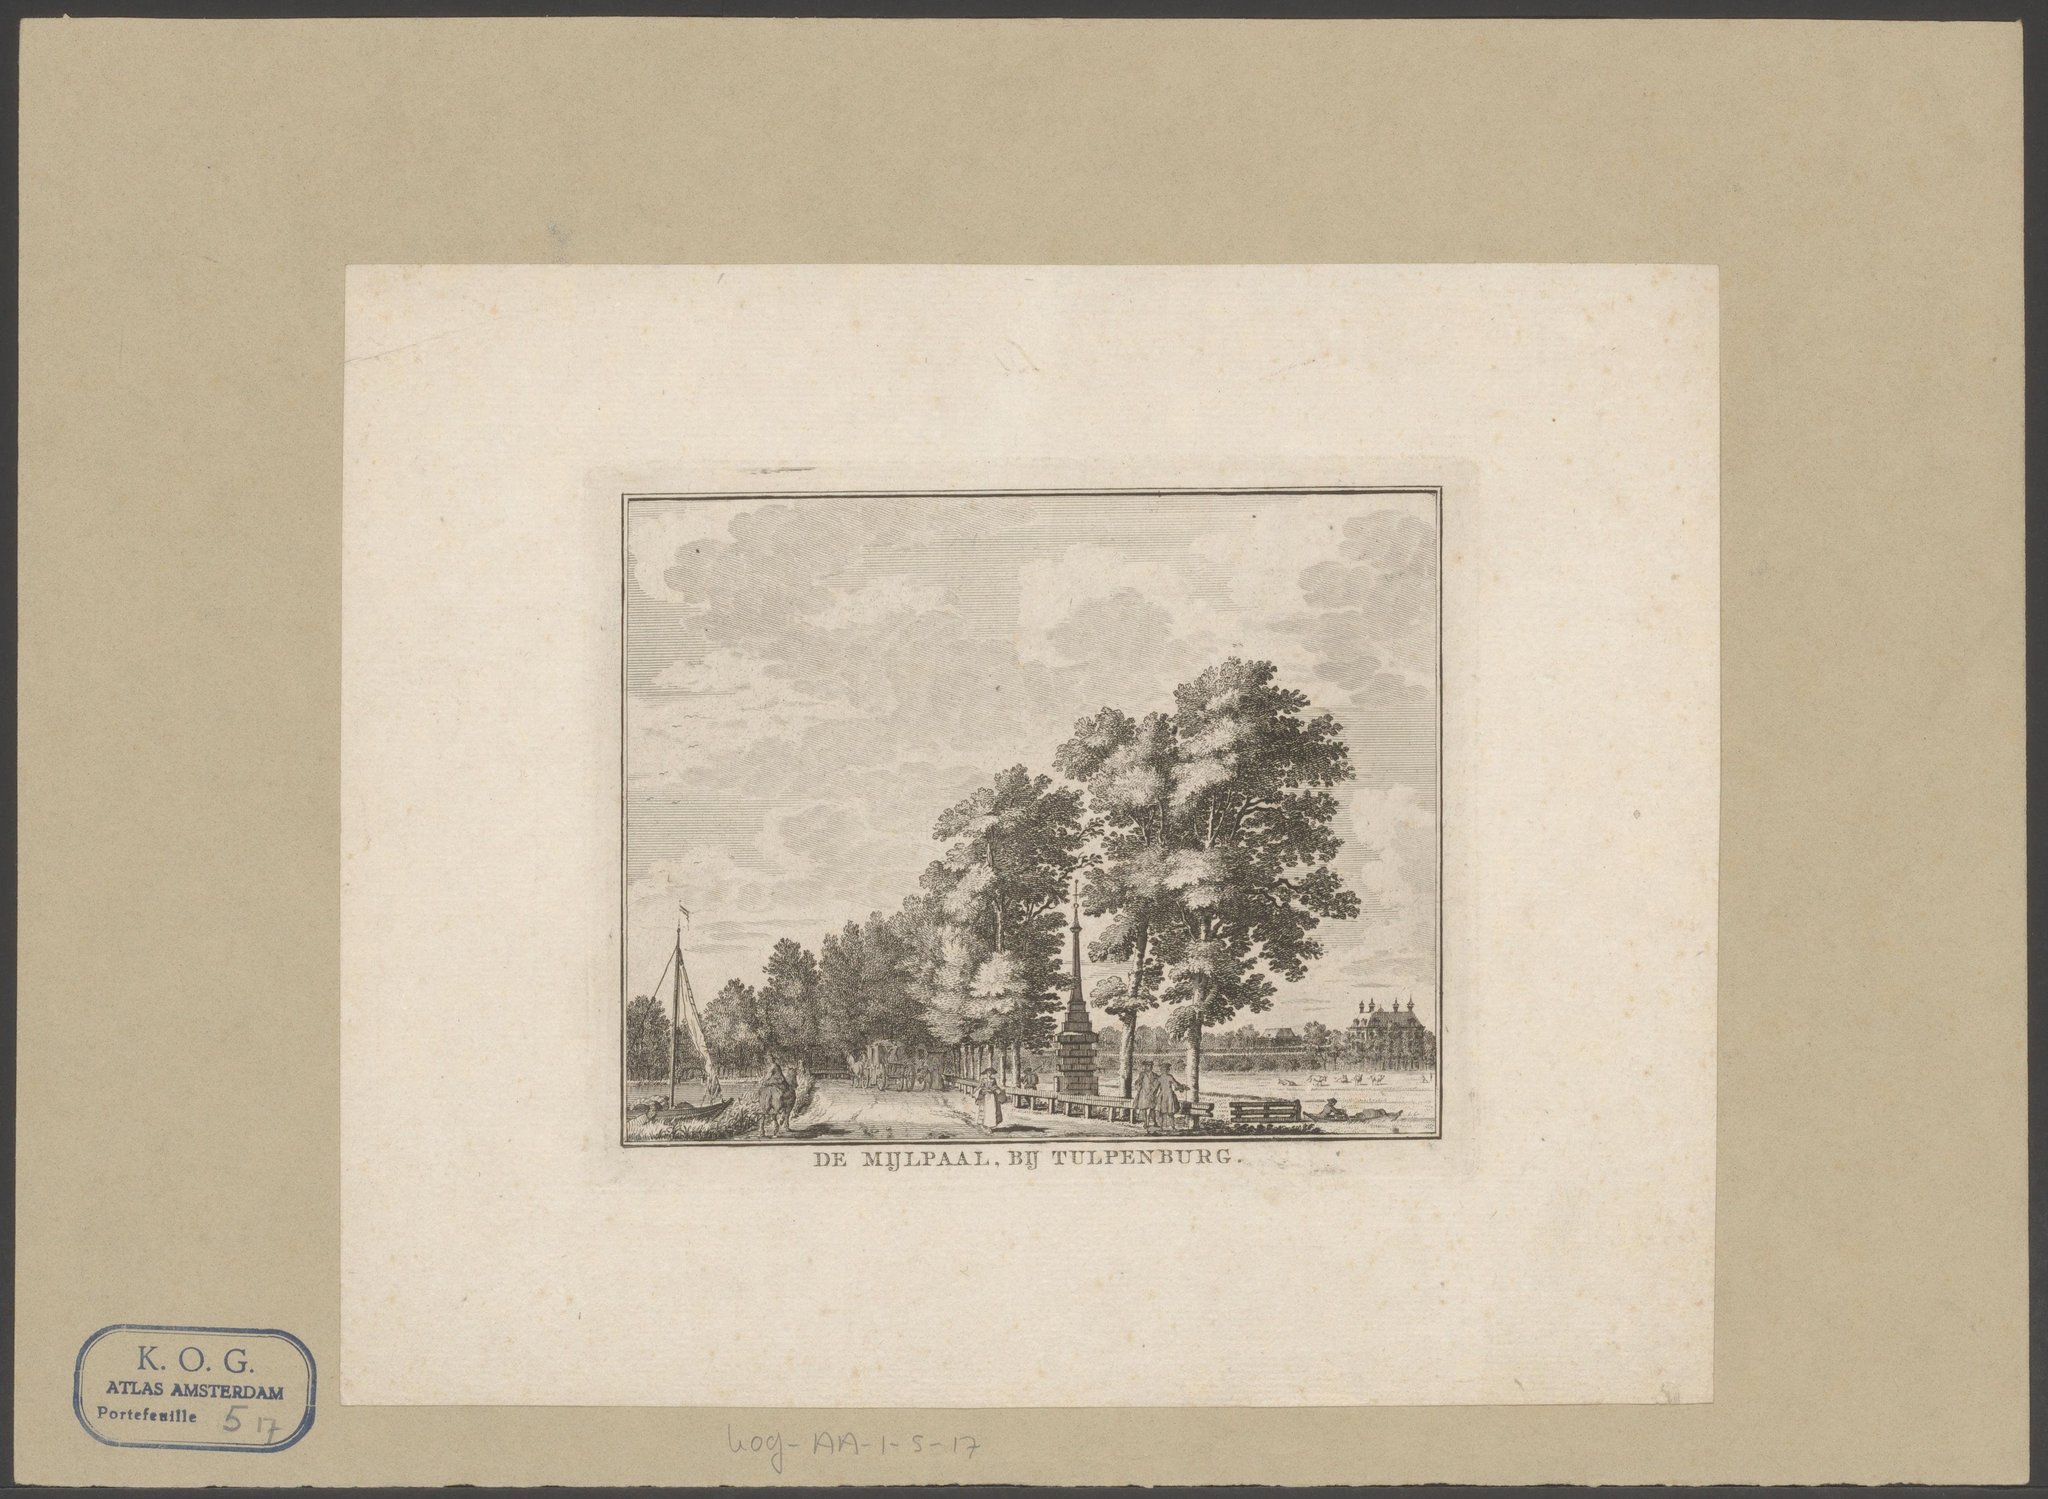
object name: print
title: Gezicht op een mijl- of banpaal en hofstede Tulpenburg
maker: jan punt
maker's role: draughtsman, print maker, publisher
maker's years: 1711-1779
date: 1736-1799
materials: paper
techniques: etching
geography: amsterdam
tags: rural housing, e.g. country-house, villa, cottage, village, road, path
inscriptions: collector's mark: ‘5 17’ Lugt 1641b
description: Andere staat van prent gebruikt in: Schoemaker, Gerrit ed. Daniel Willinks Amstellandsche Arkadia, of beschryving van de gelegenheit, toestant en gebeurtenissen van Amstellandt, met deszelfs onderhoorige dorpen, heerlykheden, ambachten, lusthoven, wateren, enz. (…). 2 delen. 1e druk. Amsterdam: Arend van Huyssteen, 1737, dl. 1, p. 104. En in: Schoemaker, Gerrit ed. Daniel Willinks Amstellandsche Arkadia, of beschryving van de gelegenheit, toestant en gebeurtenissen van Amstellandt, met deszelfs onderhoorige dorpen, heerlykheden, ambachten, lusthoven, wateren, enz. (…). 2 delen. 2e druk. Utrecht: Samuel de Waal, 1773, dl. 1, p. 101.